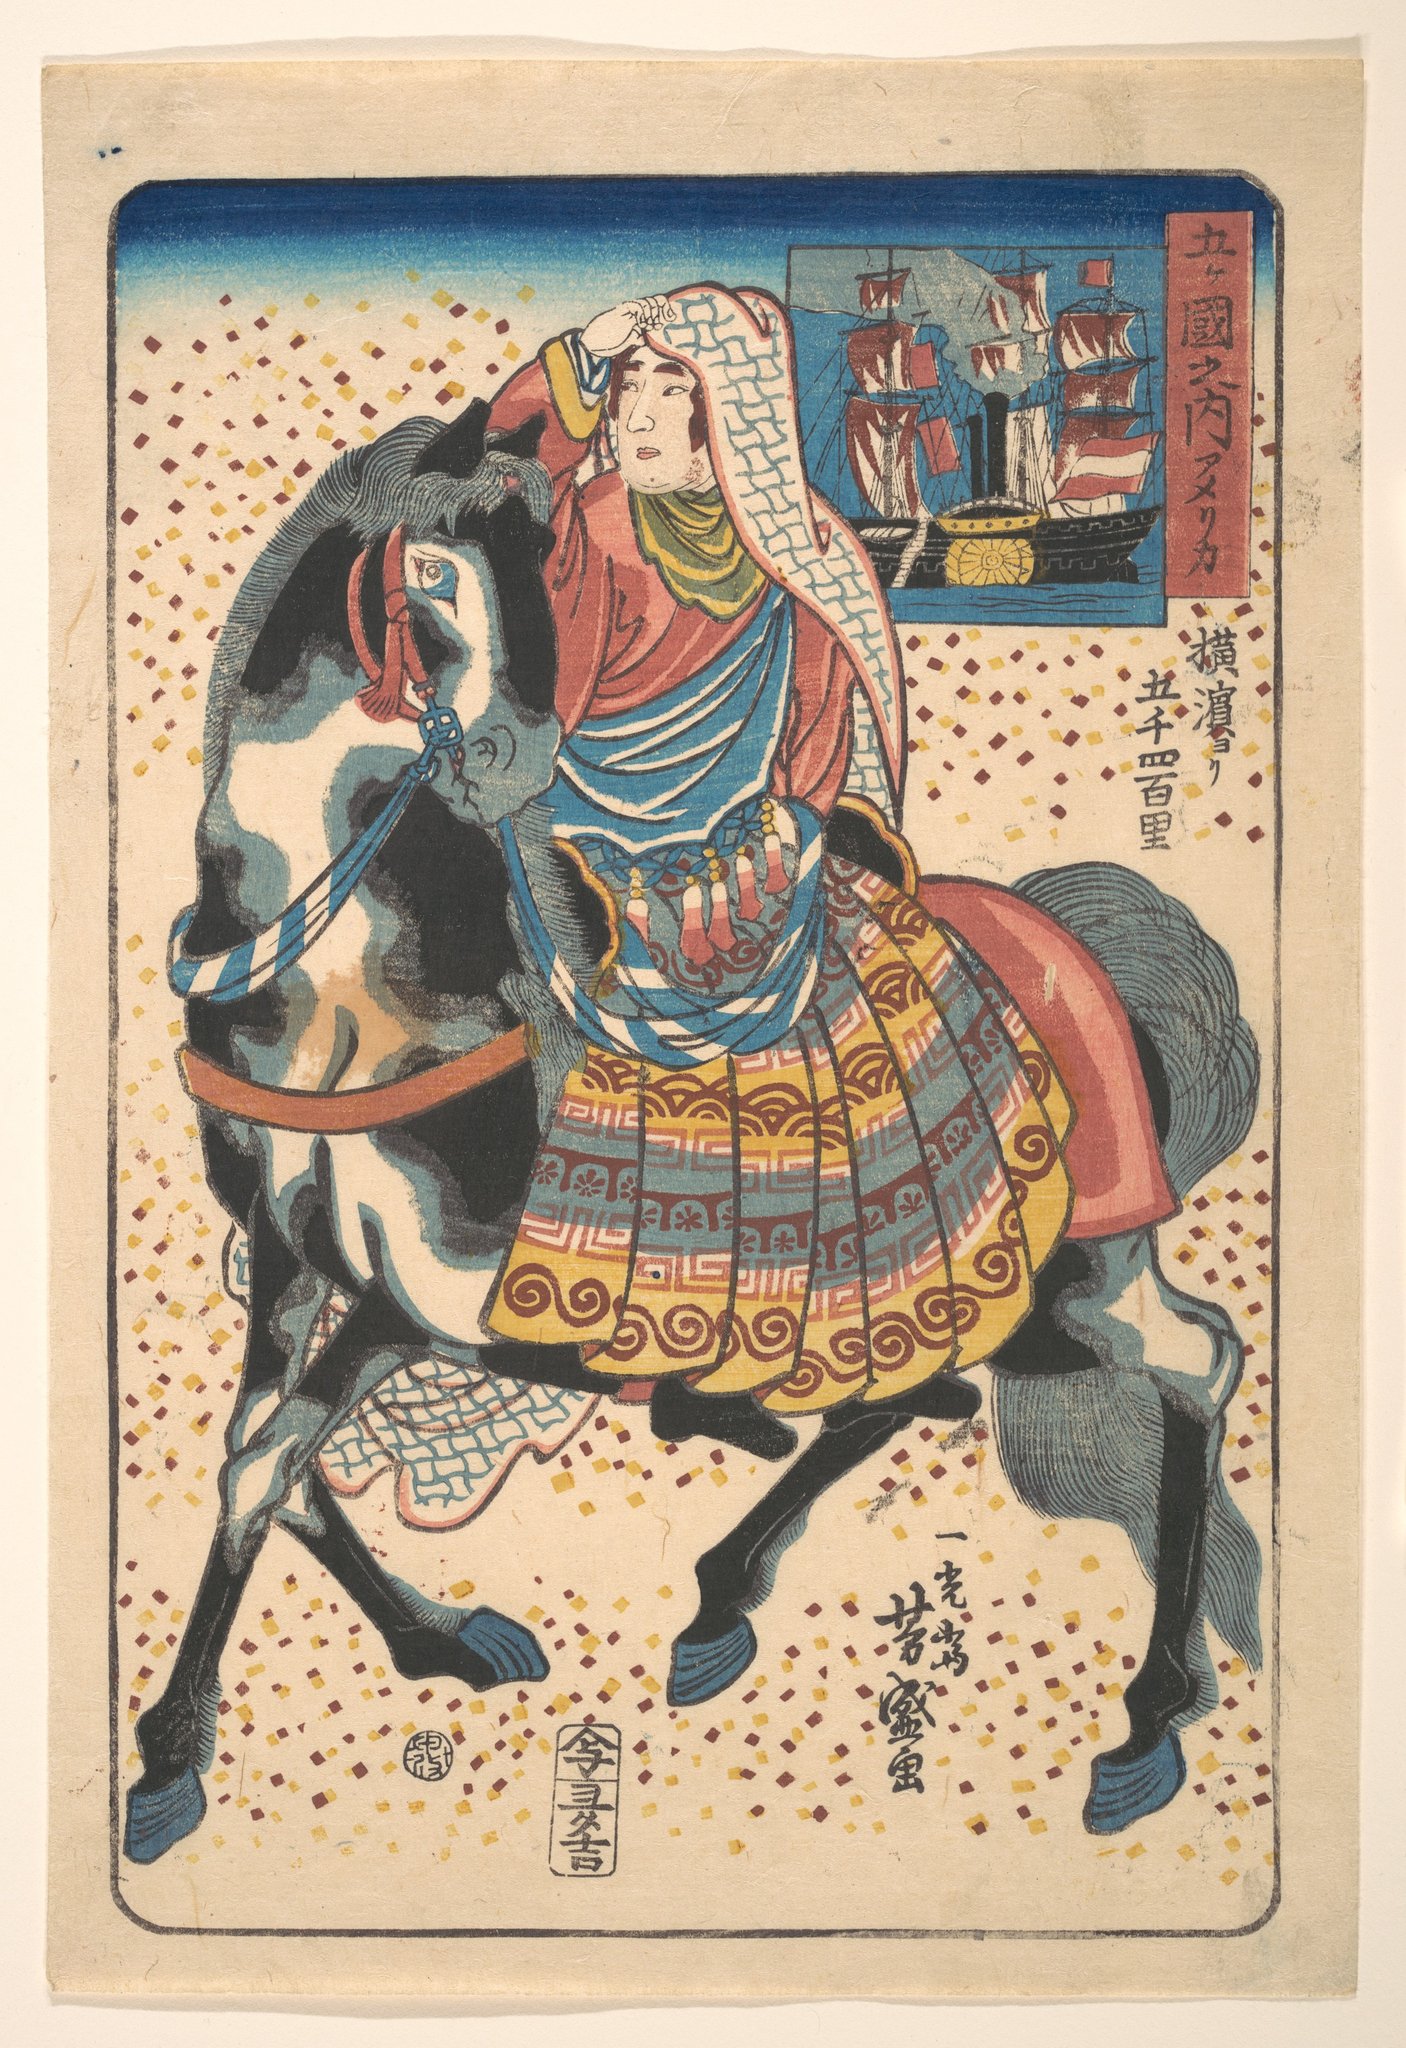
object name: print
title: “America,” from the series Five Nations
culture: japanese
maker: utagawa yoshimori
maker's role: artist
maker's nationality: japanese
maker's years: 1830-1884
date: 1860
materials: ink, paper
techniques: nishiki e, woodblock print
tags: women,horses,ships